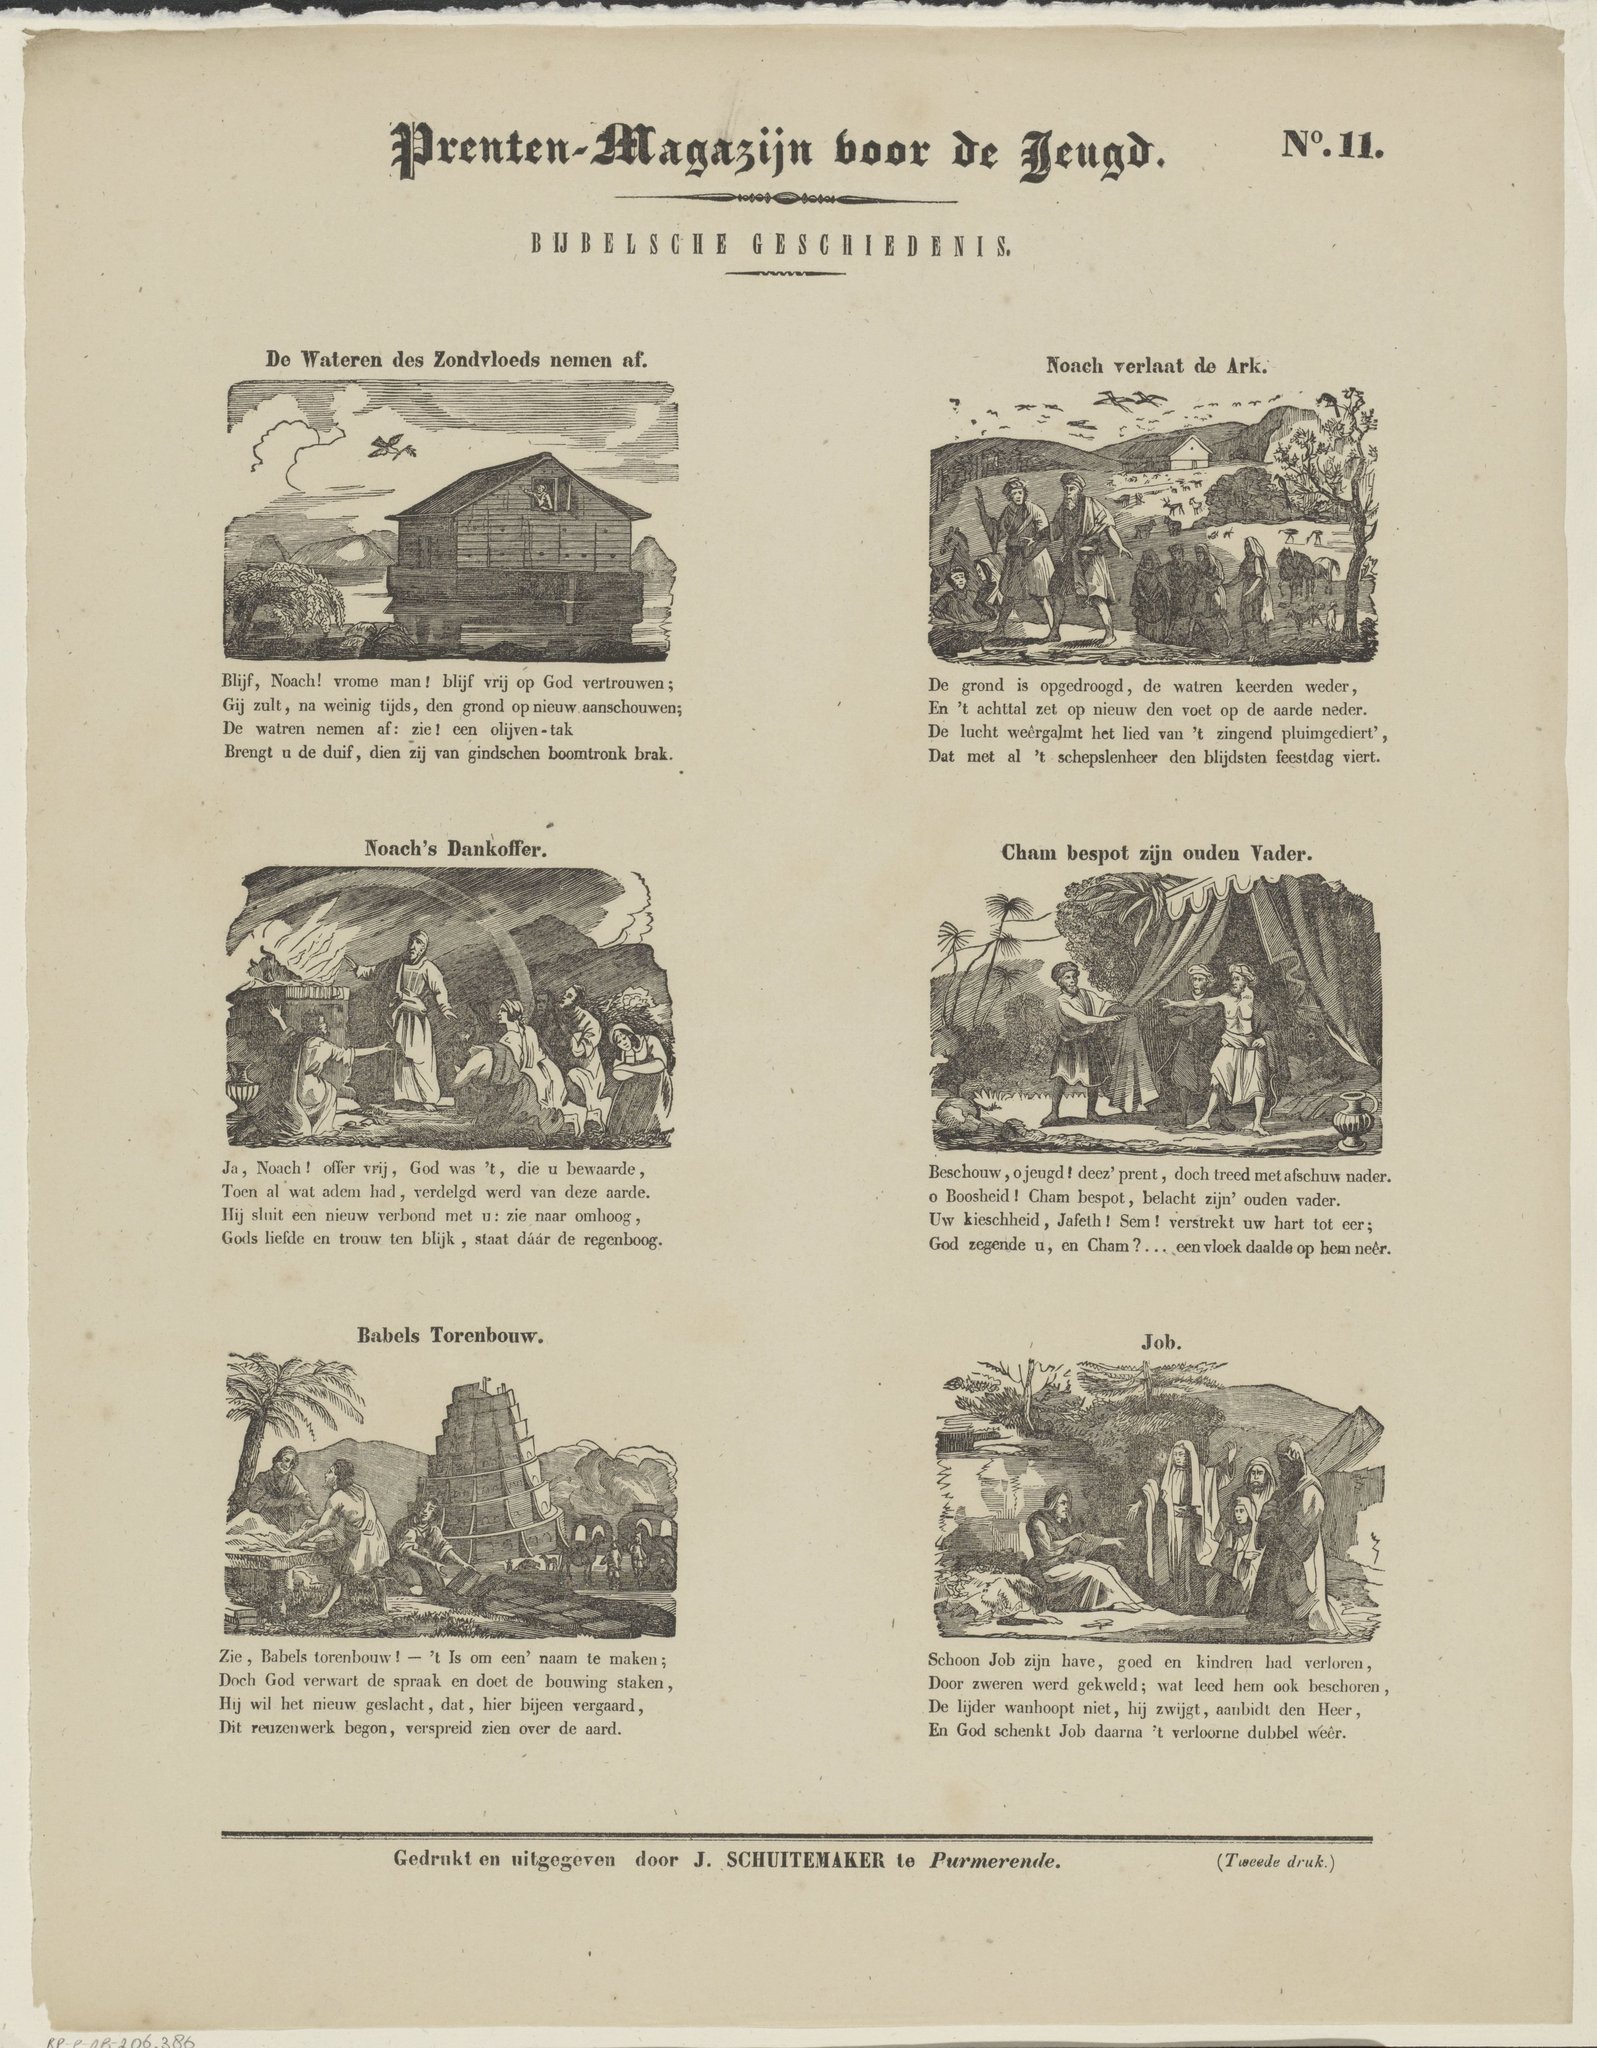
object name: print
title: Bijbelsche geschiedenis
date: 1842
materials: paper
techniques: letterpress printing, engraving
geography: purmerend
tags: job's former wealth is doubled, the tower of babel, story of noah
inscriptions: collector's mark: Lugt 2760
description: Blad met 6 voorstellingen van verhalen uit het Oude Testament, zoals Noach die de ark verlaat en de bouw van de Toren van Babel. Boven elke voorstelling een titel en onder elke voorstelling een vierregelig vers. Genummerd rechtsboven: No. 11.